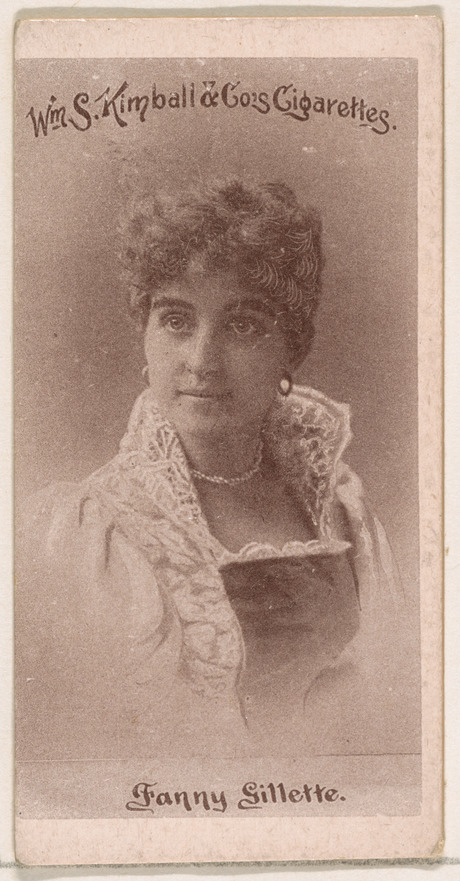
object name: print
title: Fanny Gillette, from the Actresses series (N190) issued by Wm. S. Kimball & Co.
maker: william s. kimball & company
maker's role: publisher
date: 1889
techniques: lithography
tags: portraits,women,actresses